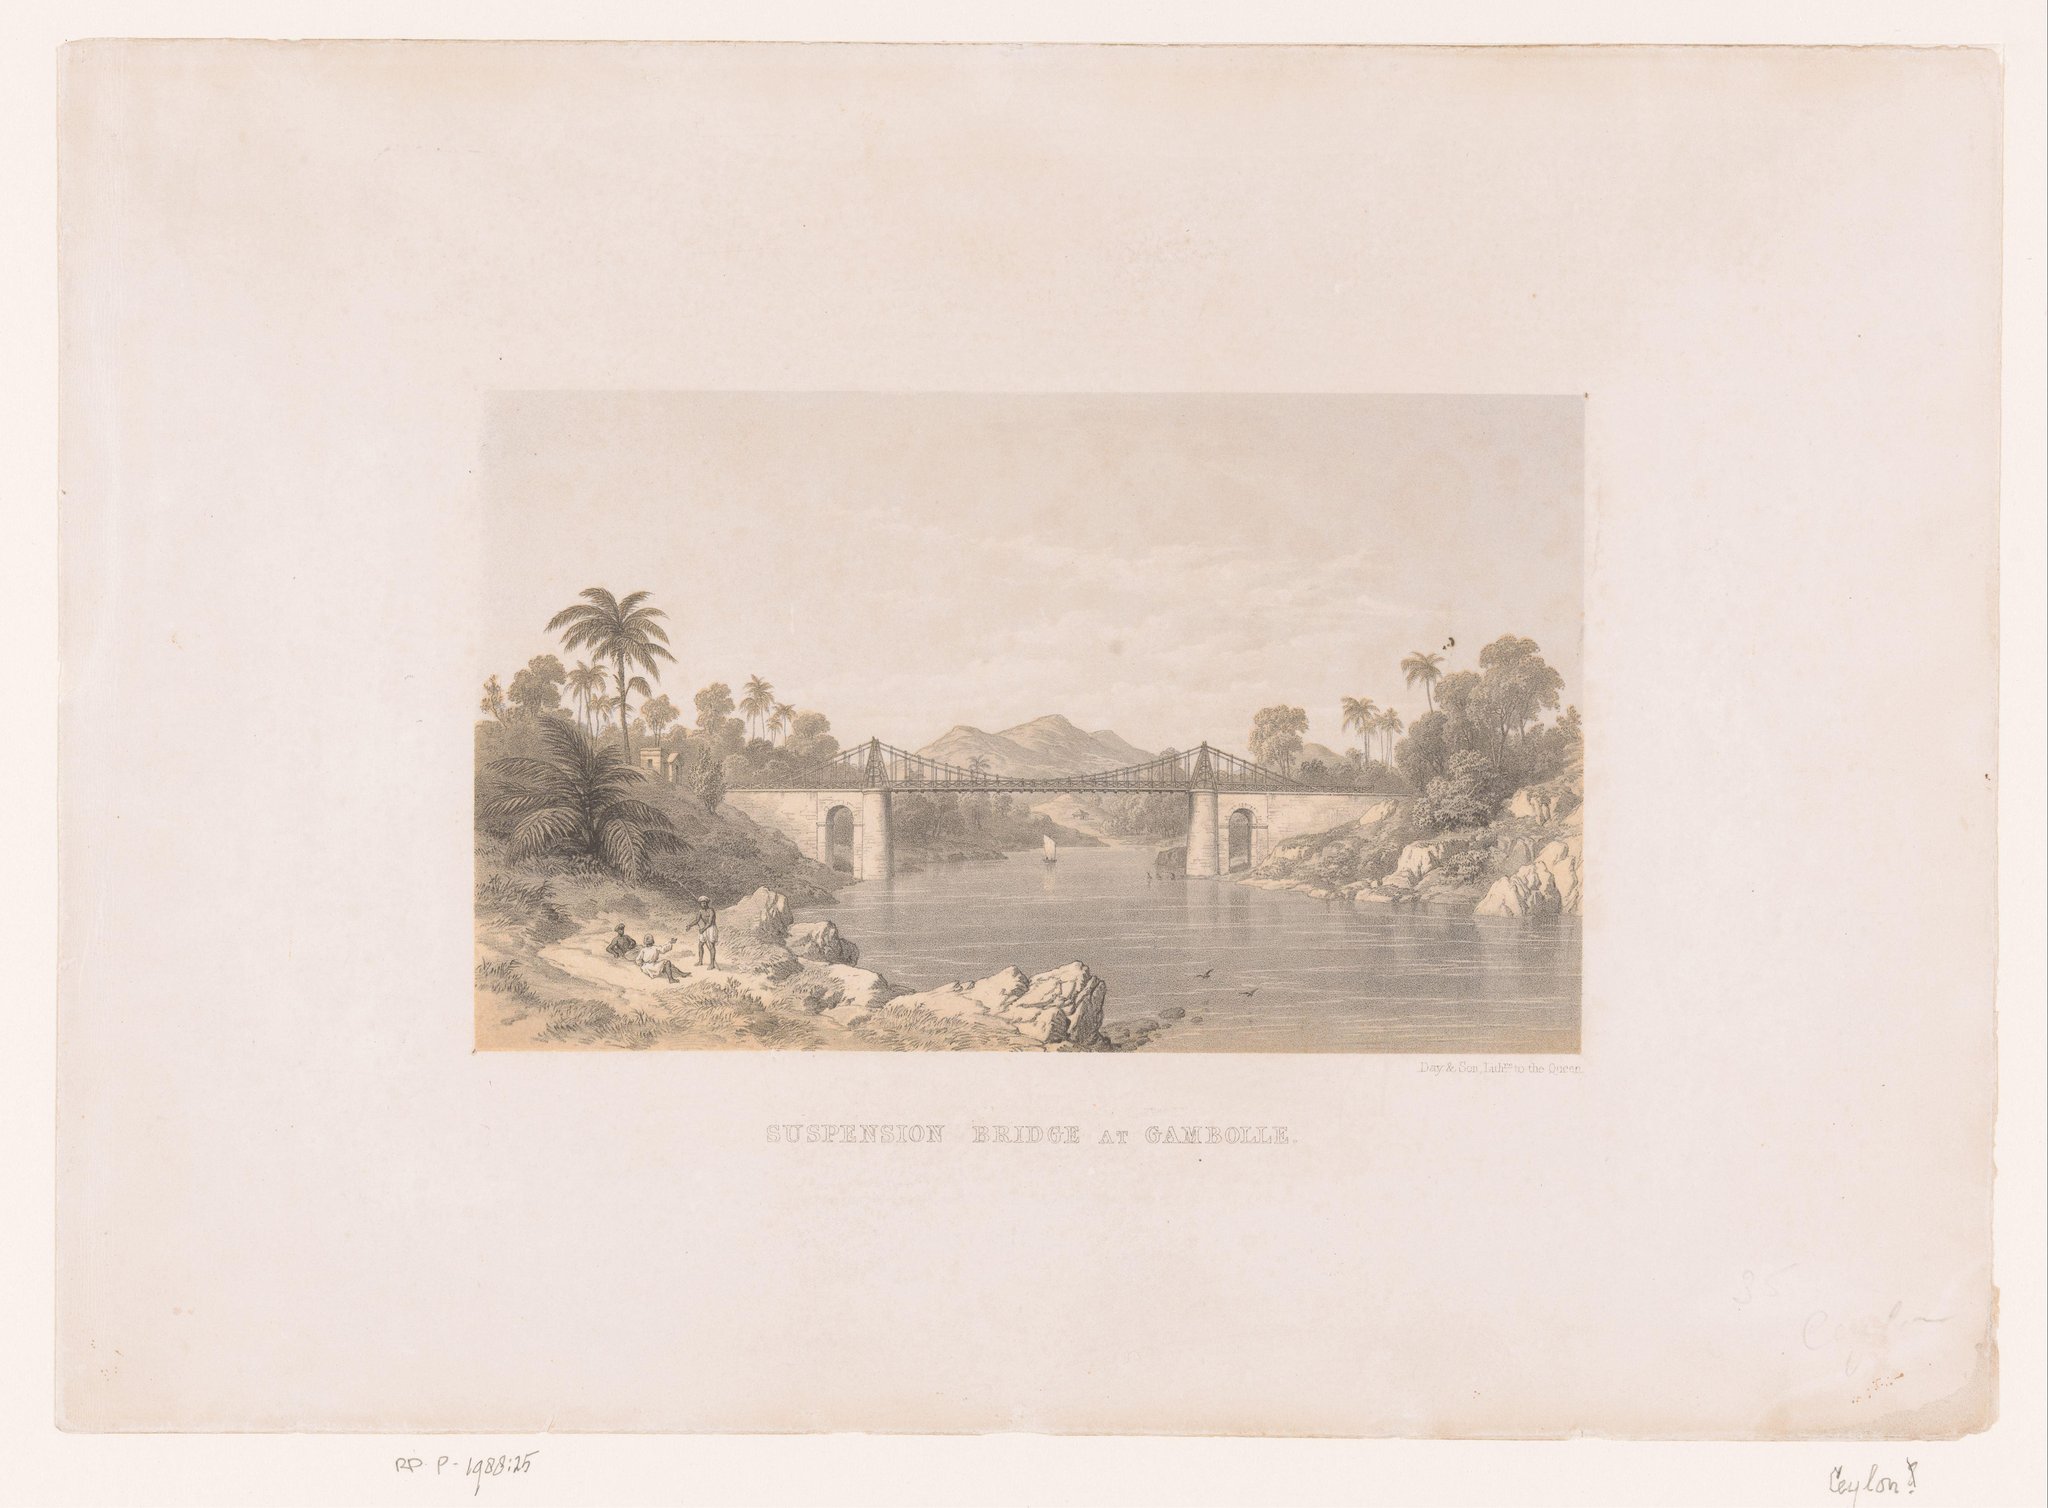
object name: print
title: Suspension Bridge at Gambolle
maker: Anonymous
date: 1824-1913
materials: paper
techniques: lithograph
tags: suspension bridge, landscape with bridge, viaduct or aqueduct, sri lanka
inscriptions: collector's mark: Lugt 2228, collector's mark: Lugt 2760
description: Drie figuren rusten op de voorgrond. Onder de brug een kleine zeilboot. Op het opzetvel de annotatie Ceylon; mogelijk is Gambolle dan Gampola.